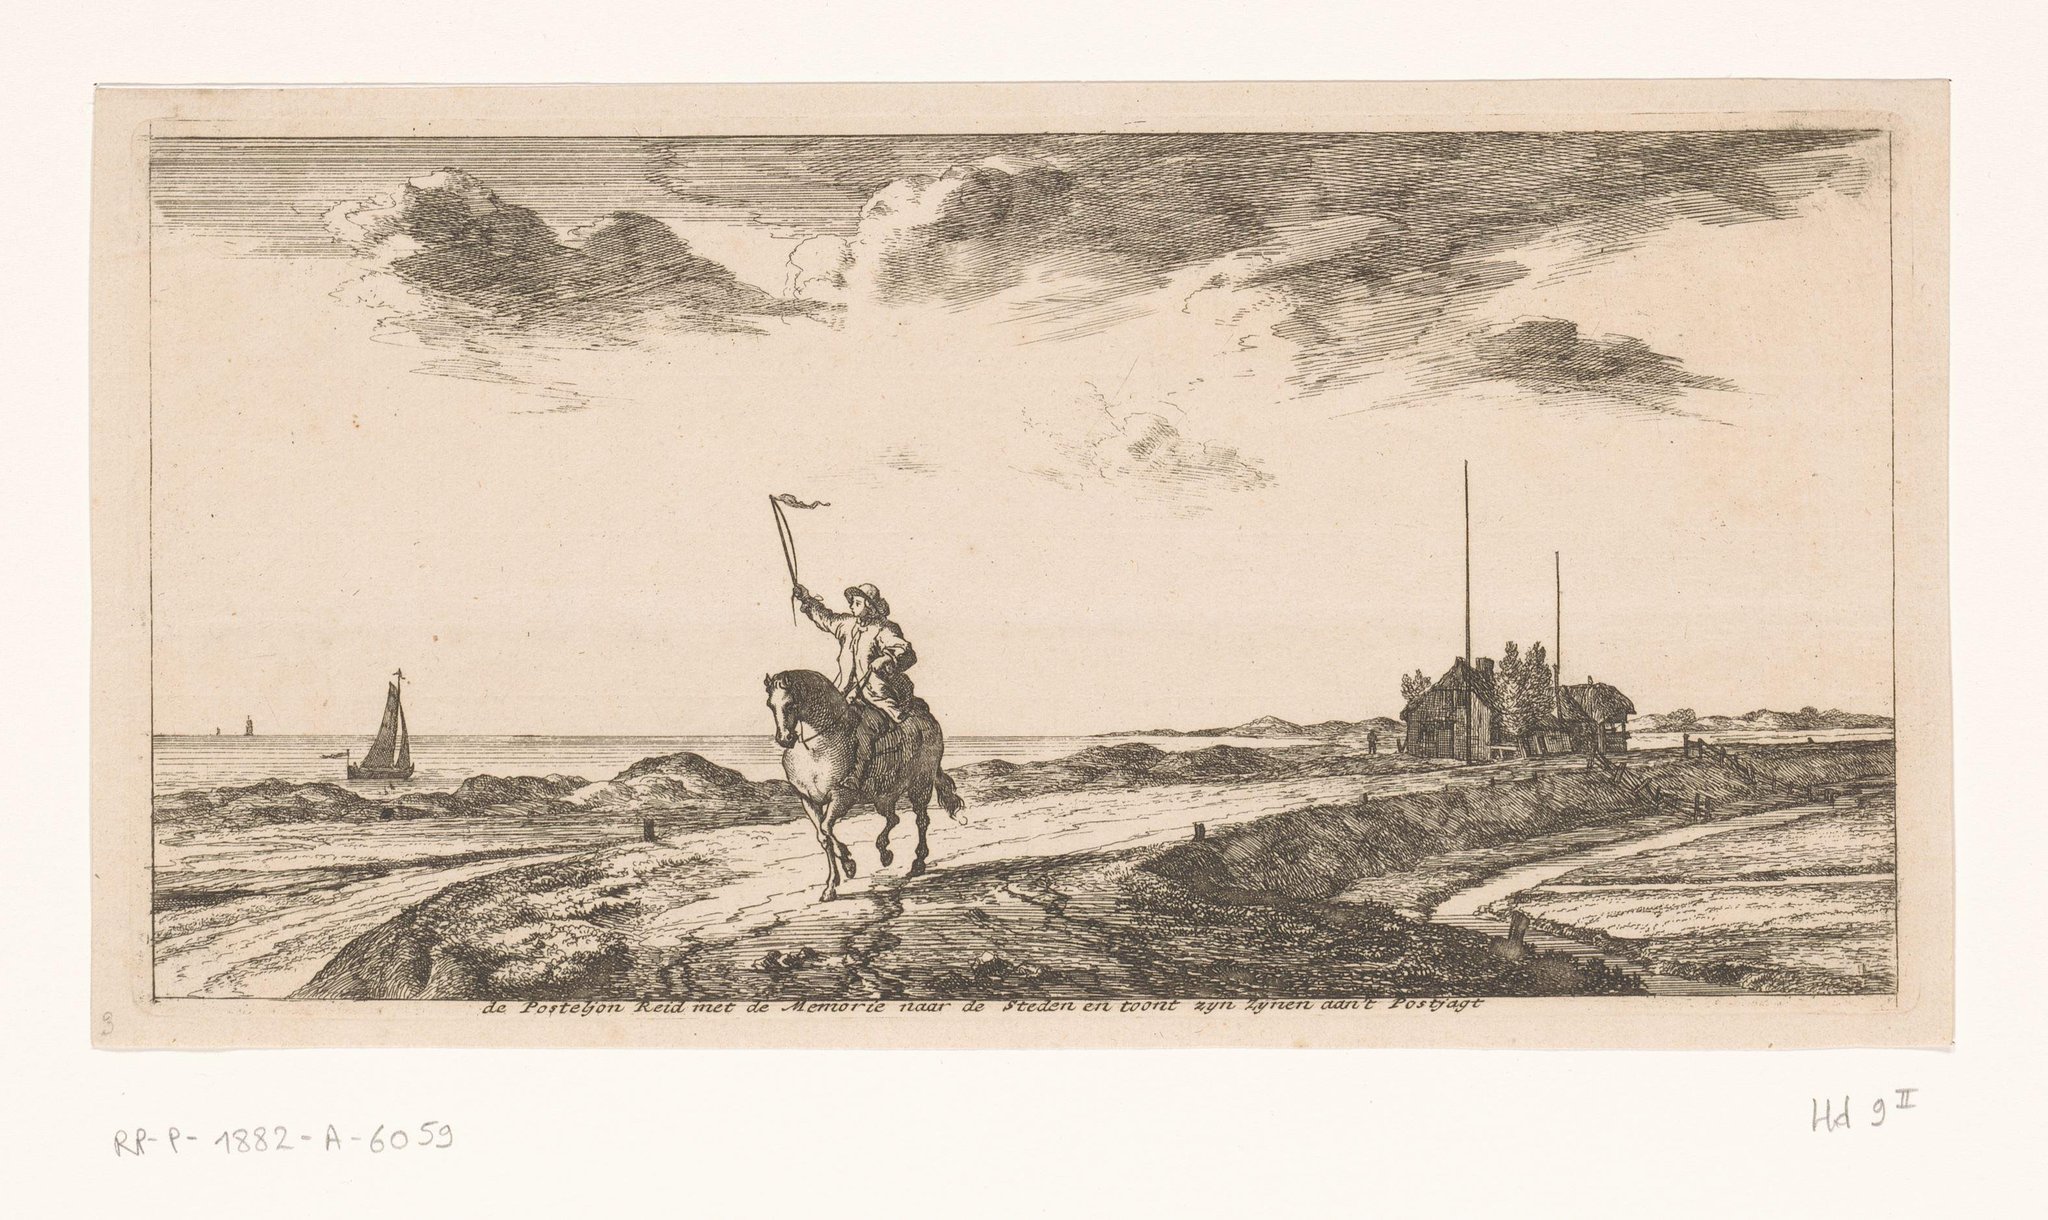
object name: print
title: Postkaart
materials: paper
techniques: etching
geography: rotterdam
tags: postal service, postman, ships (in general) - cc - more than one ship, beach, sea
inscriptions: collector's mark: Lugt 2228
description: De postbode rijdt met zijn paard langs het strand. Hij signaleert naar een voorbijvarend schip. De prent heeft een Nederlands onderschrift met uitleg.